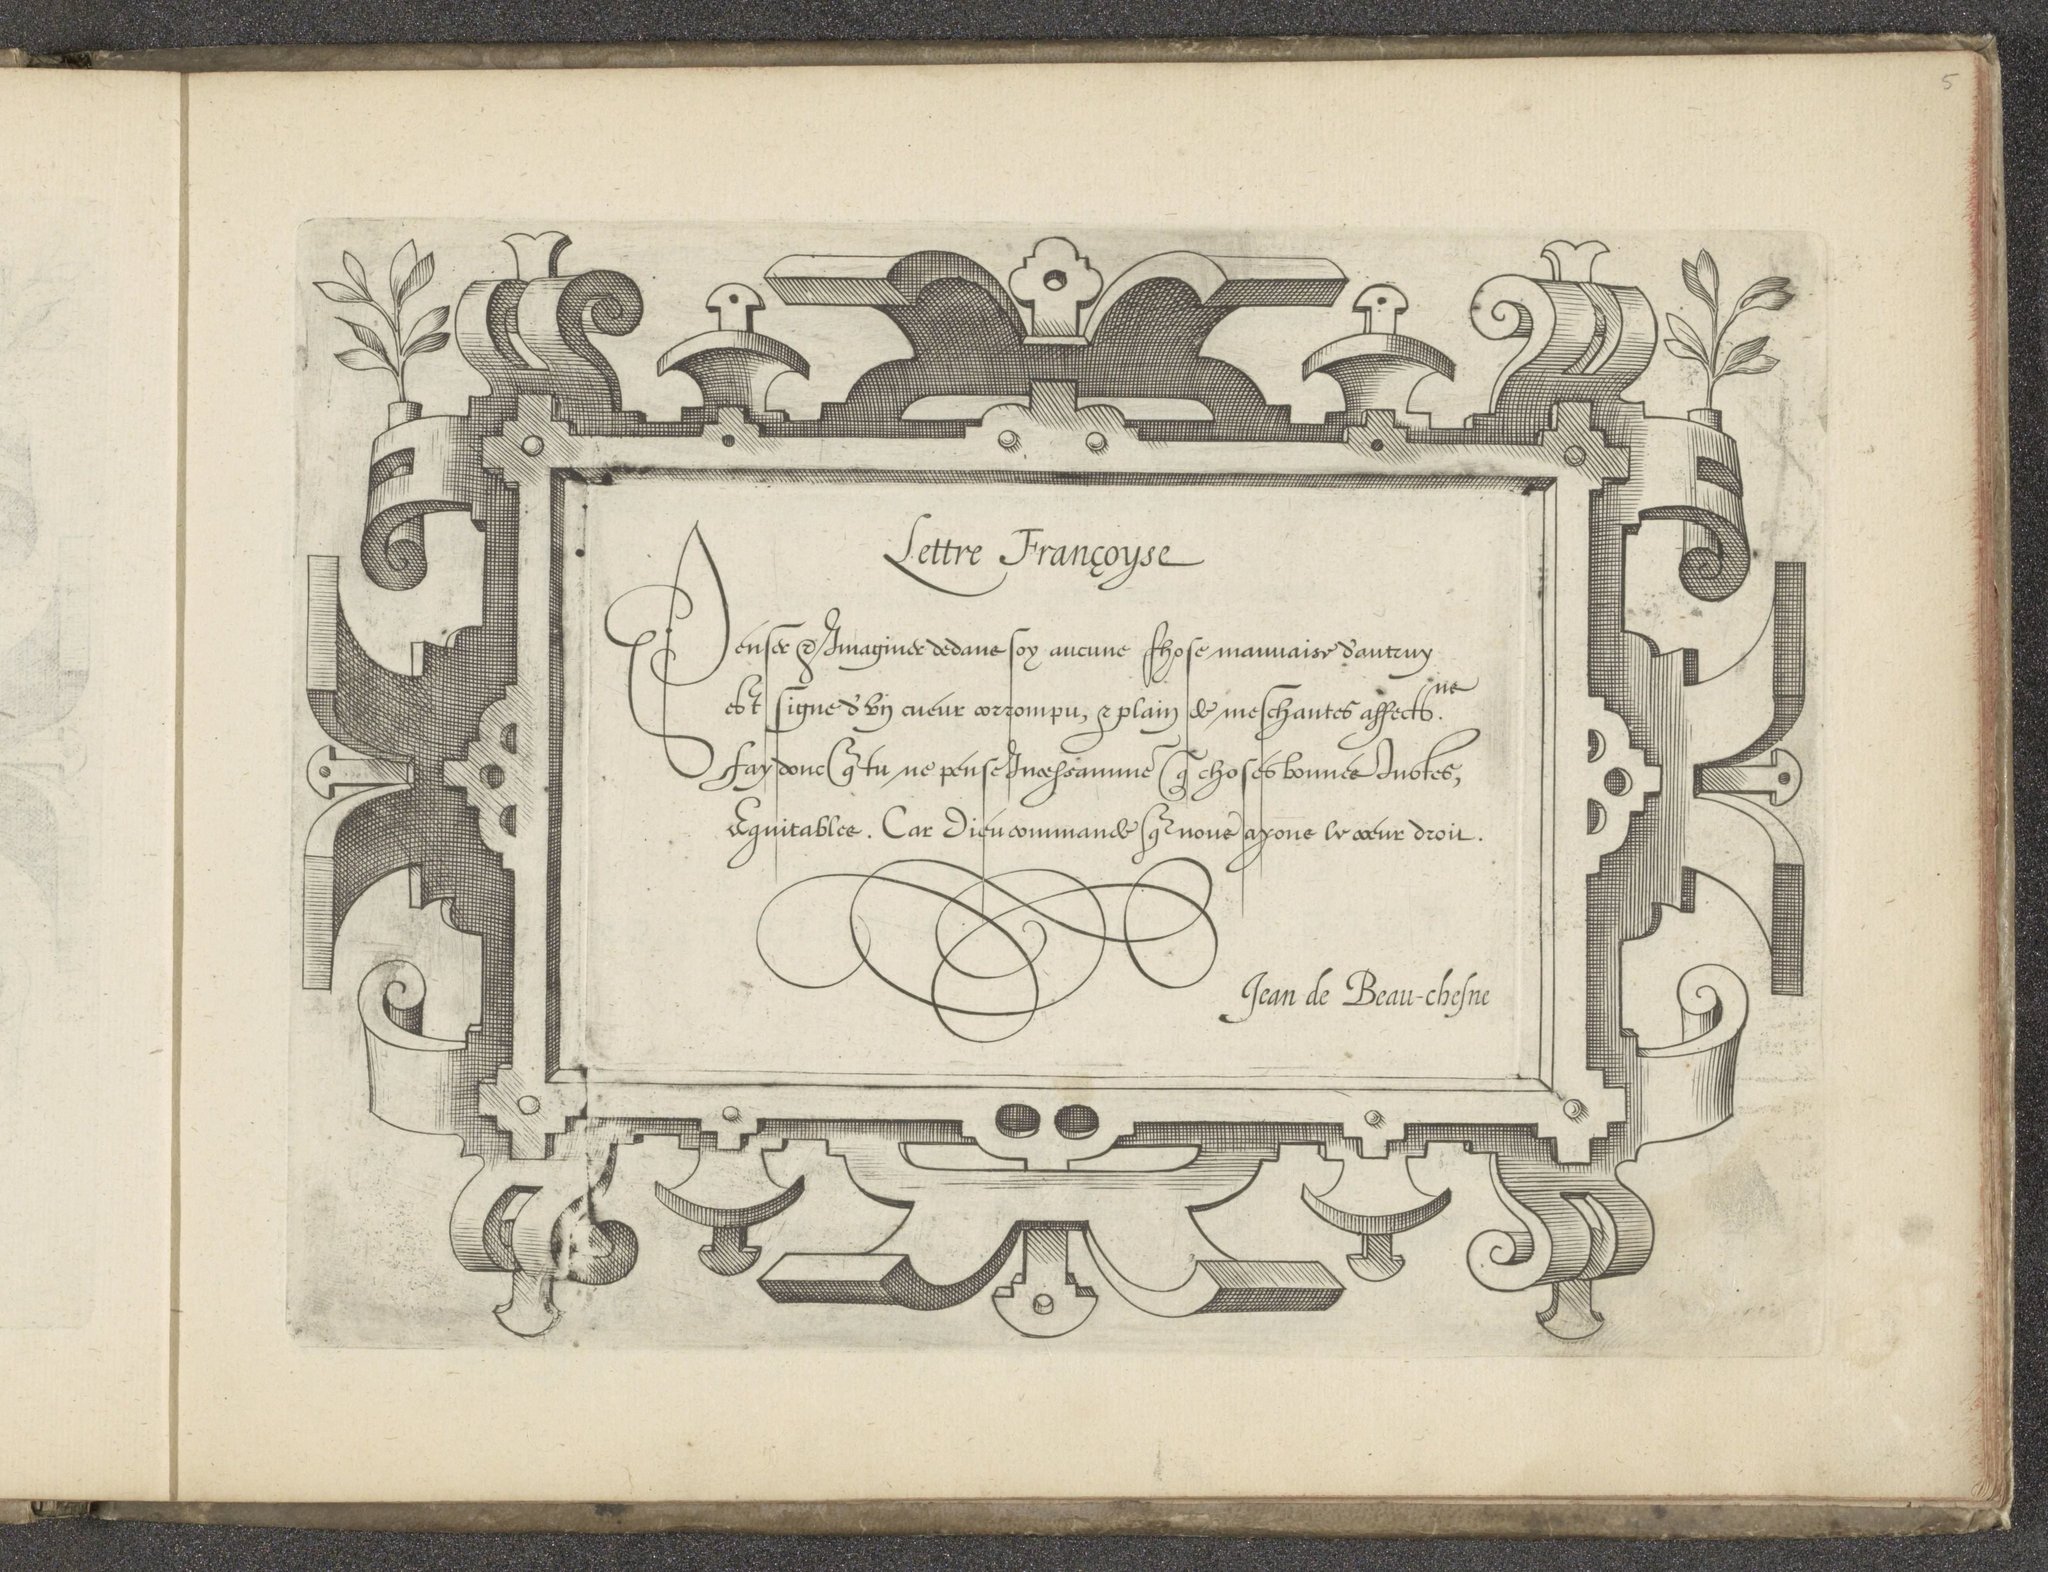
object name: album leaf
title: Schrijfvoorbeeld: Penser et Imaginer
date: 1614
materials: paper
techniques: engraving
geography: amsterdam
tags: scrollwork, strapwork ~ ornament, ornament ~ cartouche, calligraphy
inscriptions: signature and date: ‘Op titelblad: Judoco Hondio celatore. Amstelodami apud Joannem Janssonium. 1614’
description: Schrijfvoorbeeld in een gotische hand met een titel en vier regels tekst in het Frans. Het voorbeeld is gevat in een rolwerkcartouche. De prent maakt deel uit van een album.